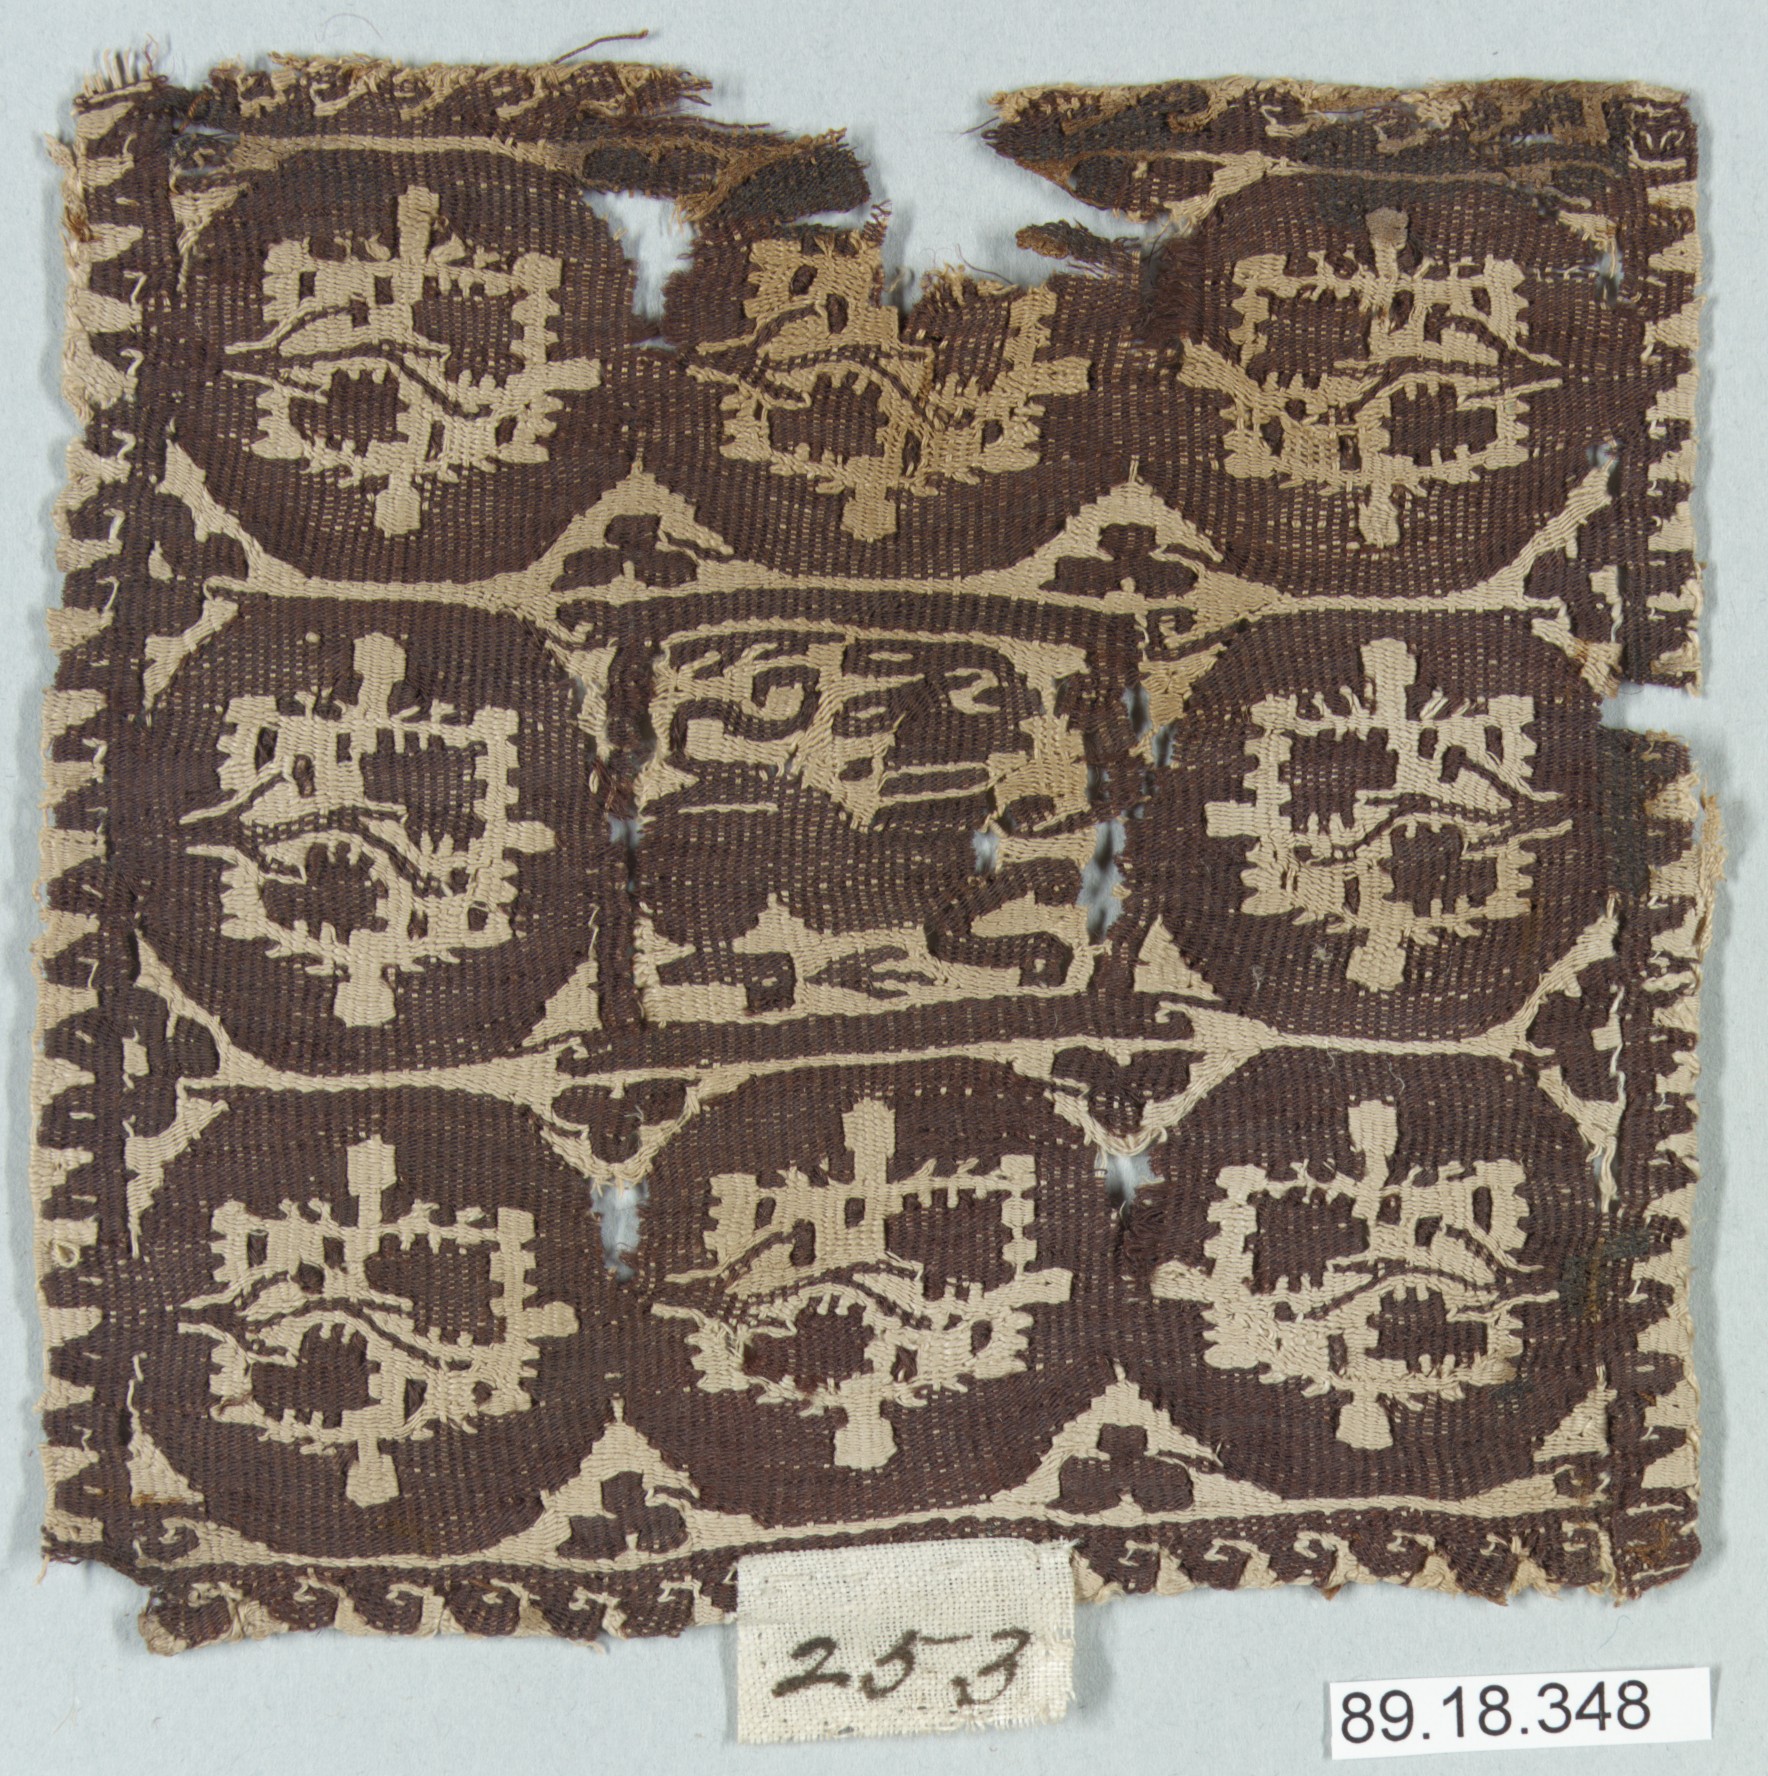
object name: textile fragment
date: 301-400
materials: linen, wool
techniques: weave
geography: egypt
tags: animals